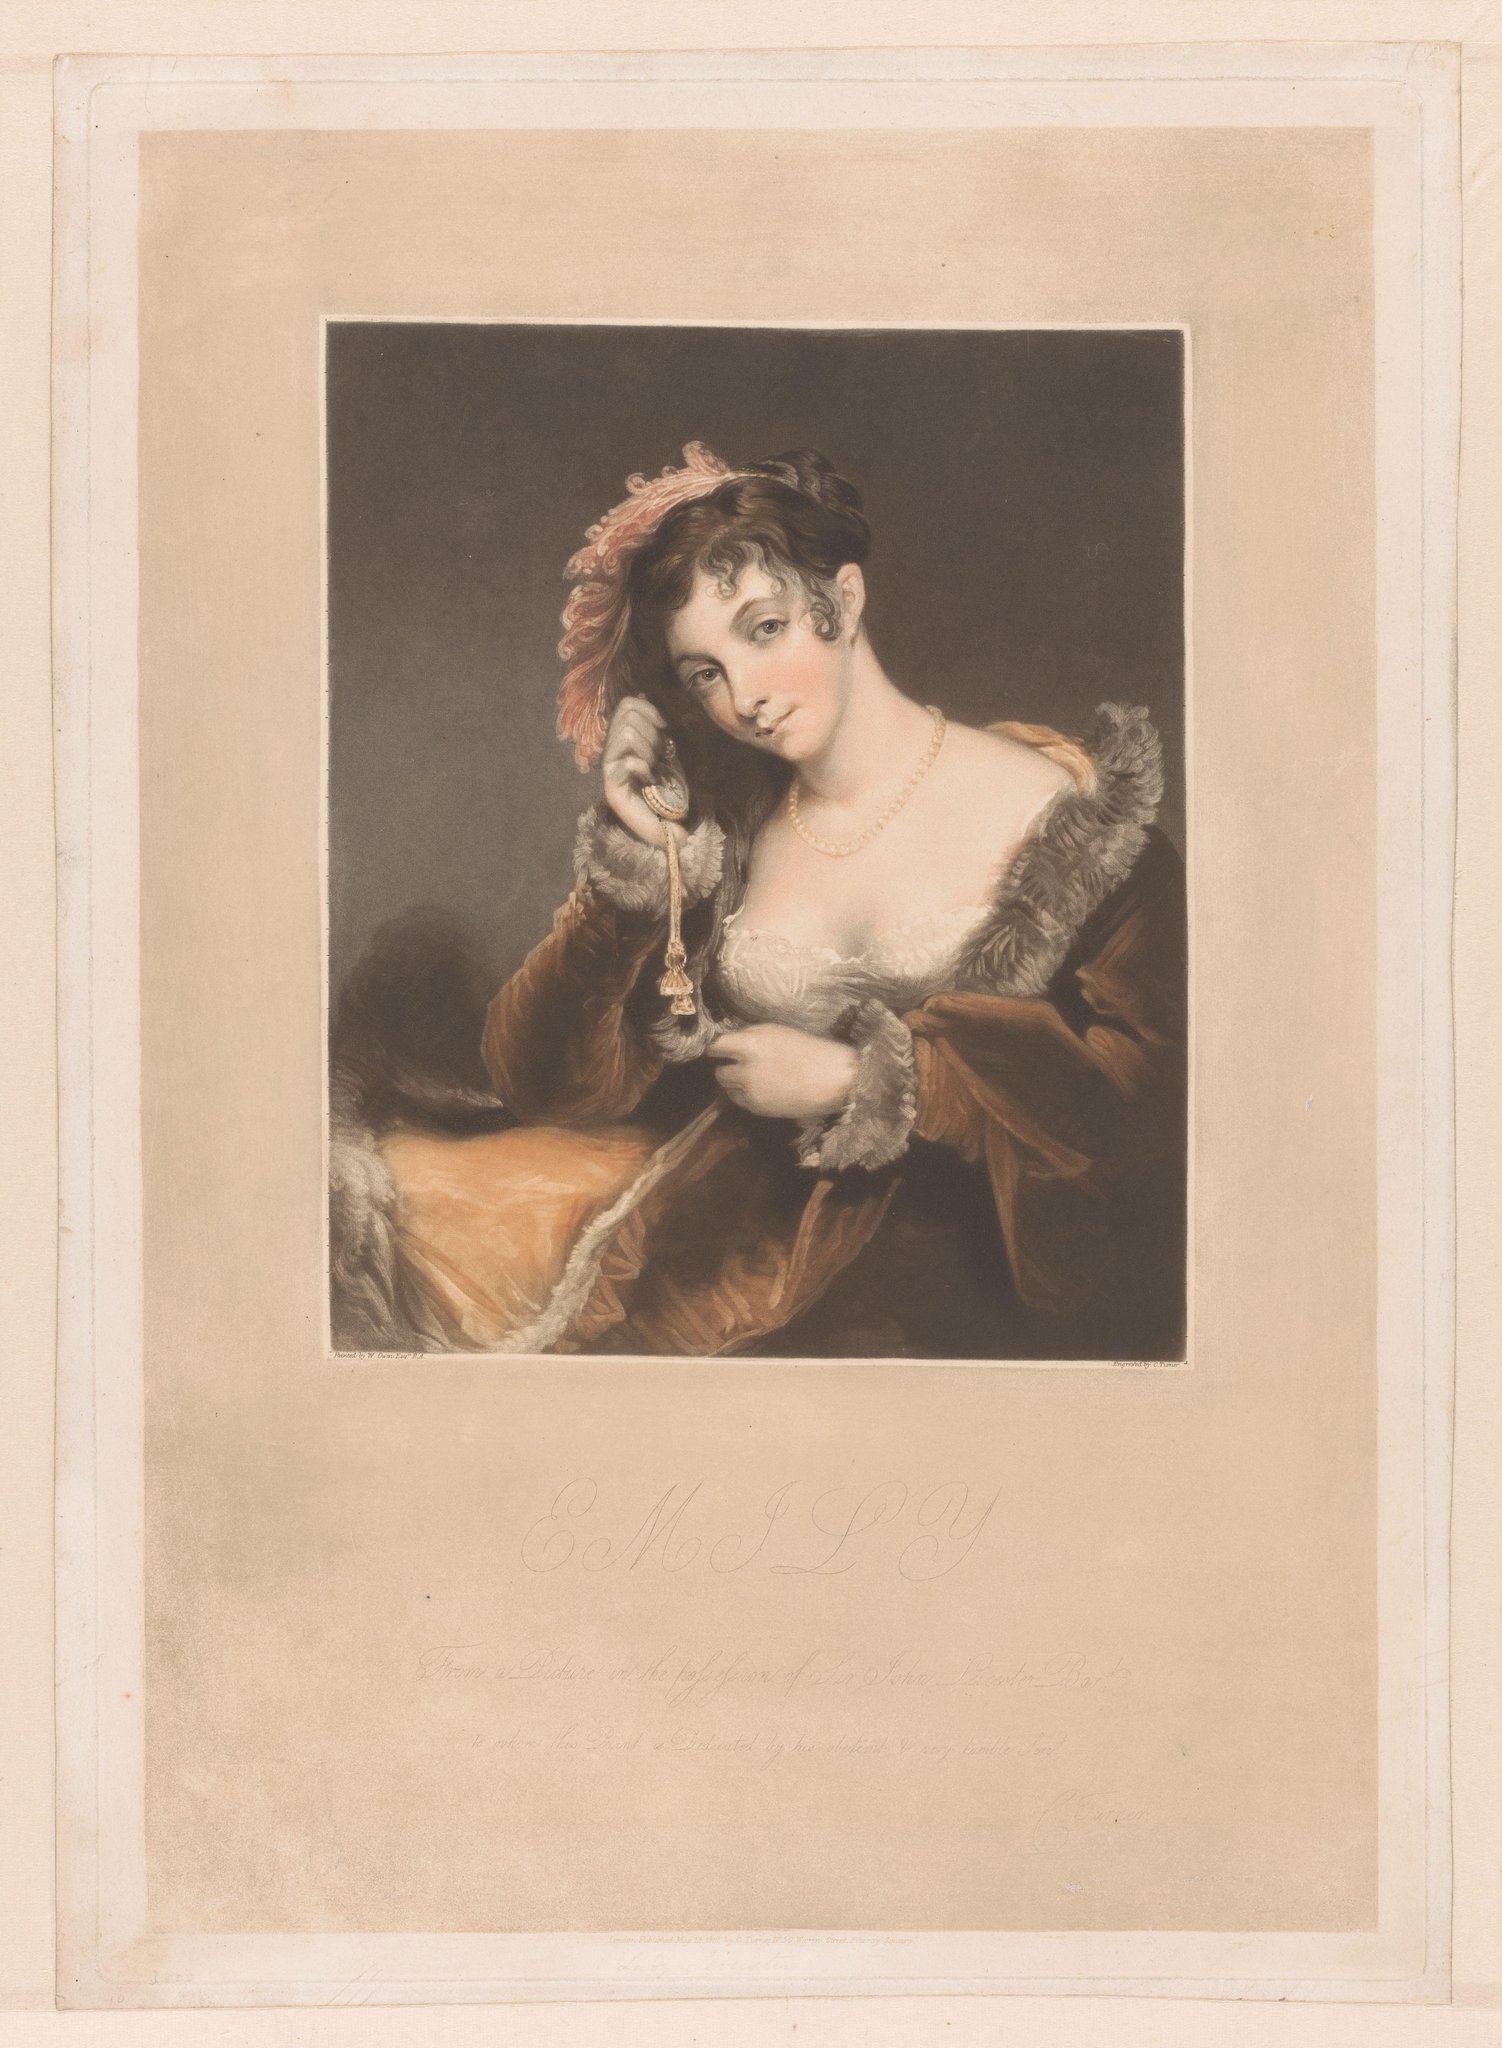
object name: print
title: Emily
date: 1805-1810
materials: paper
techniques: color mezzotint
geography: london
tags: historical persons - bb - woman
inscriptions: date